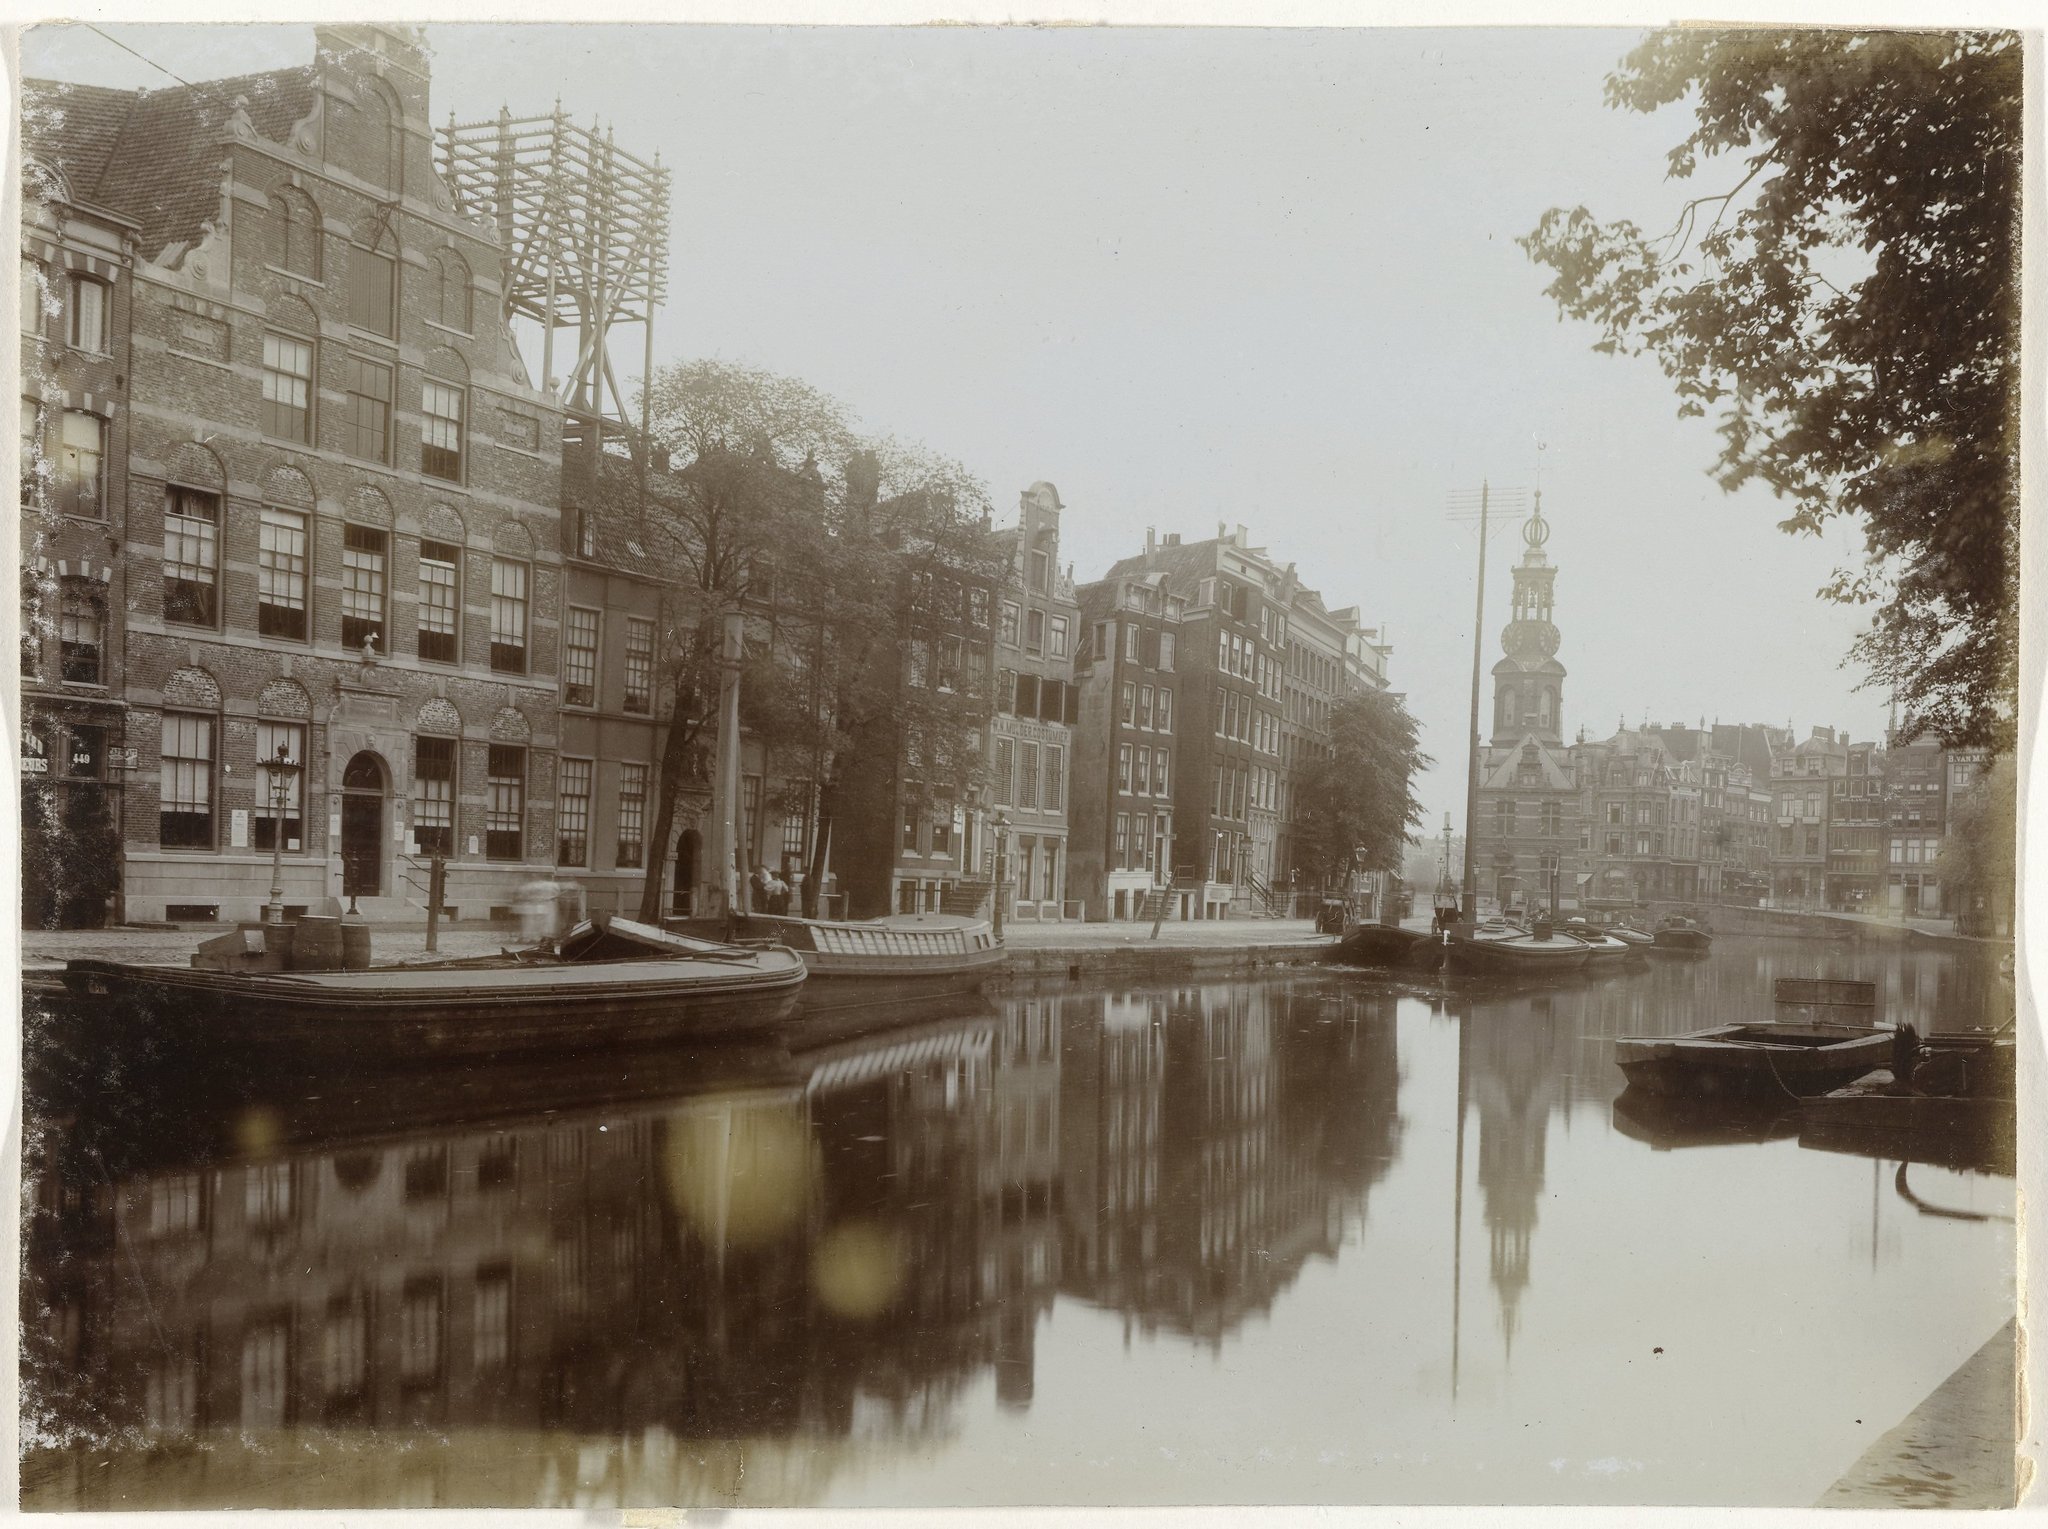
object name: photograph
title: Gezicht over de Singel met de Munttoren aan het Muntplein, gezien vanaf de Bloemenmarkt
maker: Anonymous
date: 1900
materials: paper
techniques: collodion silver print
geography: amsterdam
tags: tower, clock tower ~ monumental adornment, canals, waters (in city)